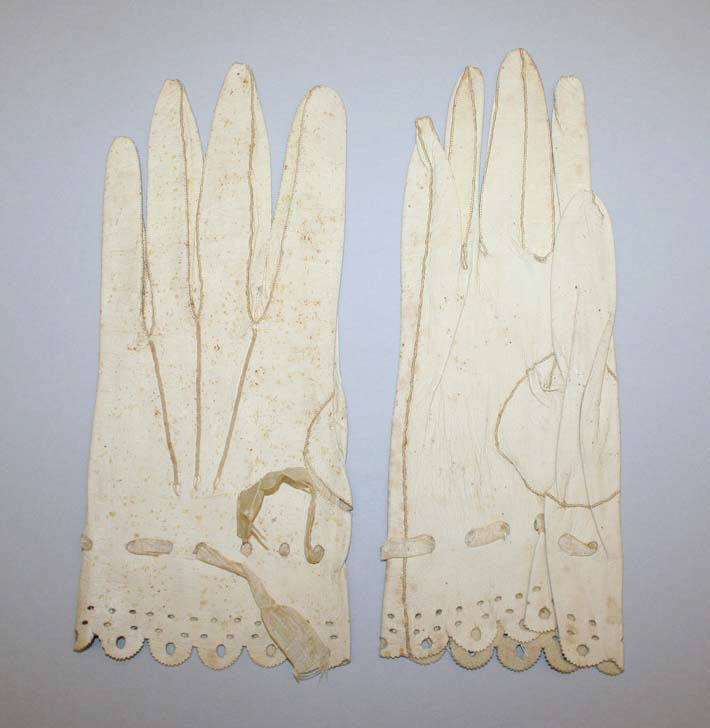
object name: glove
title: Gloves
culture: american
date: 1876-1900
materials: leather, silk